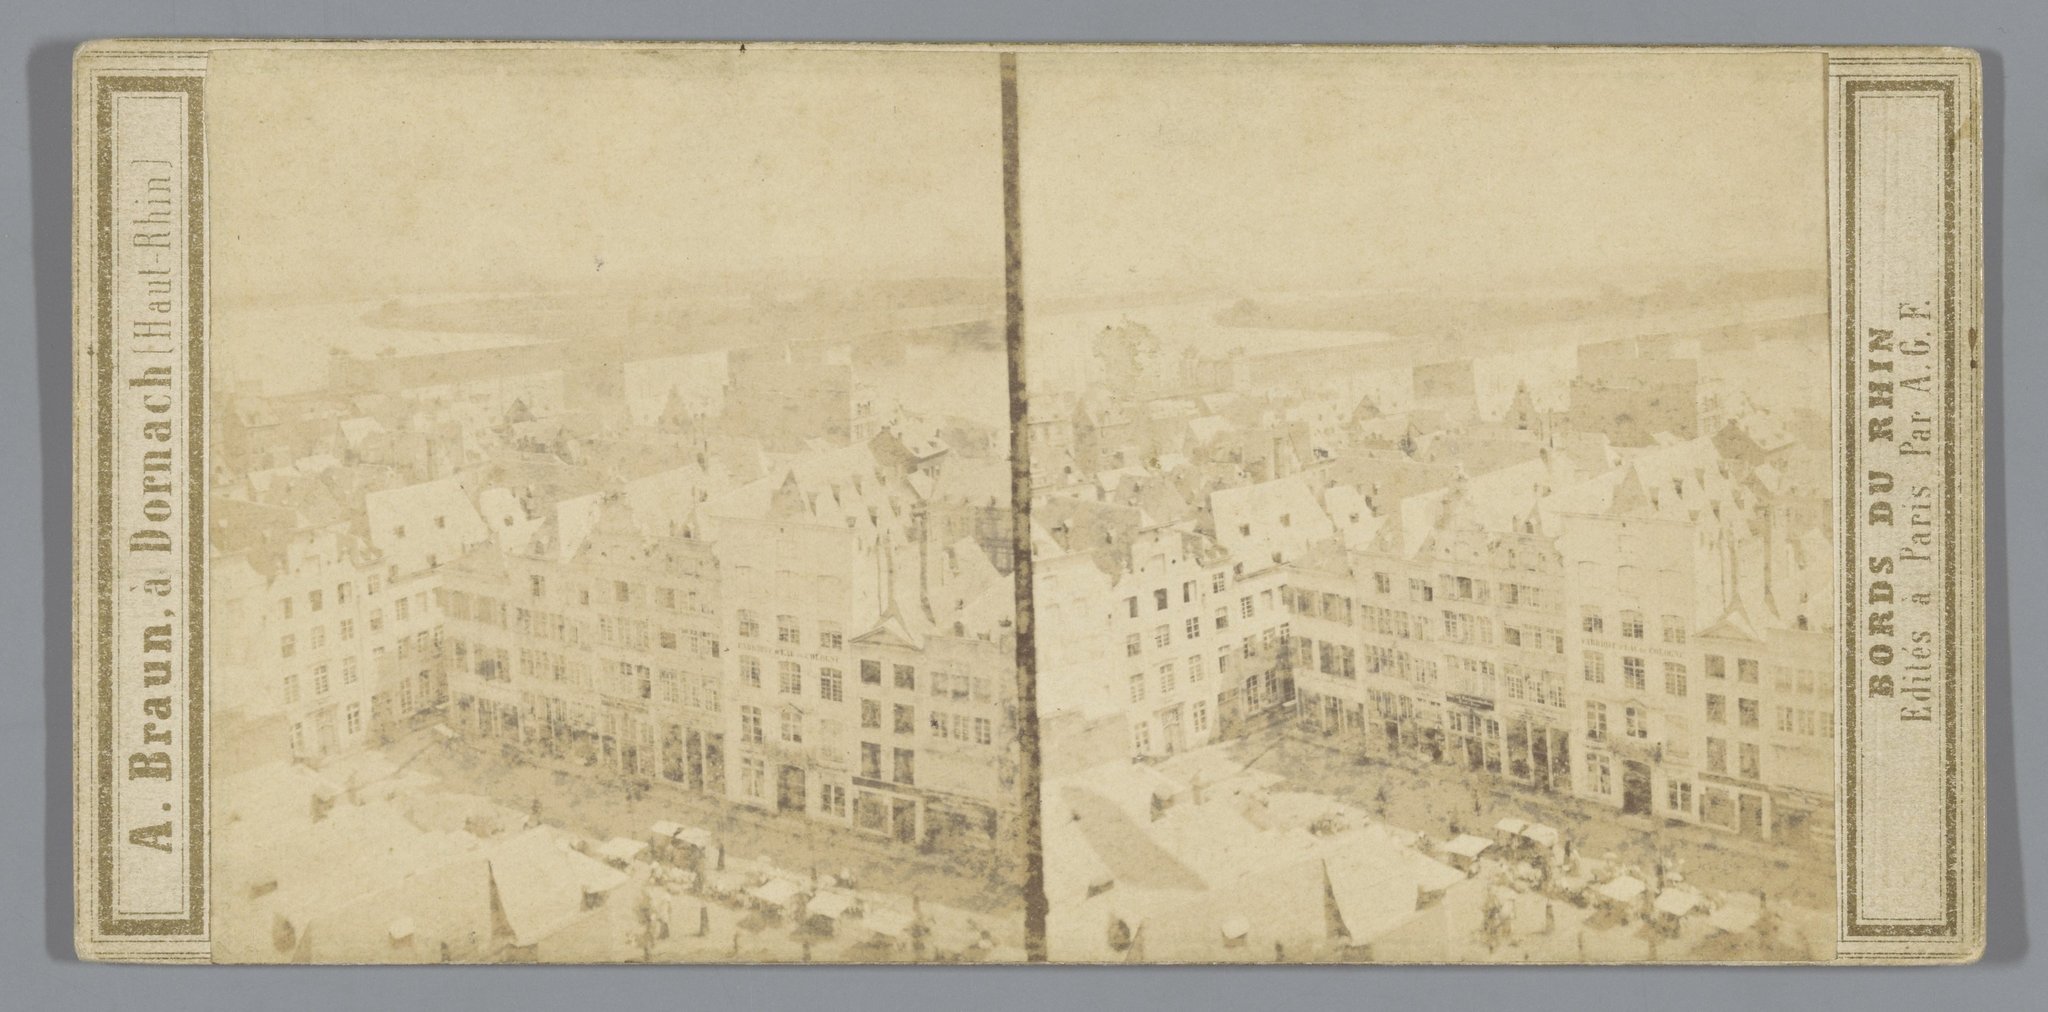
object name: stereograph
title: Bords du Rhin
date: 1860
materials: cardboard, paper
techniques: albumen print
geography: paris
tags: city-view in general; 'veduta', river, cologne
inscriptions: number: ‘794.’, inscription: ‘P.’, number: ‘120’